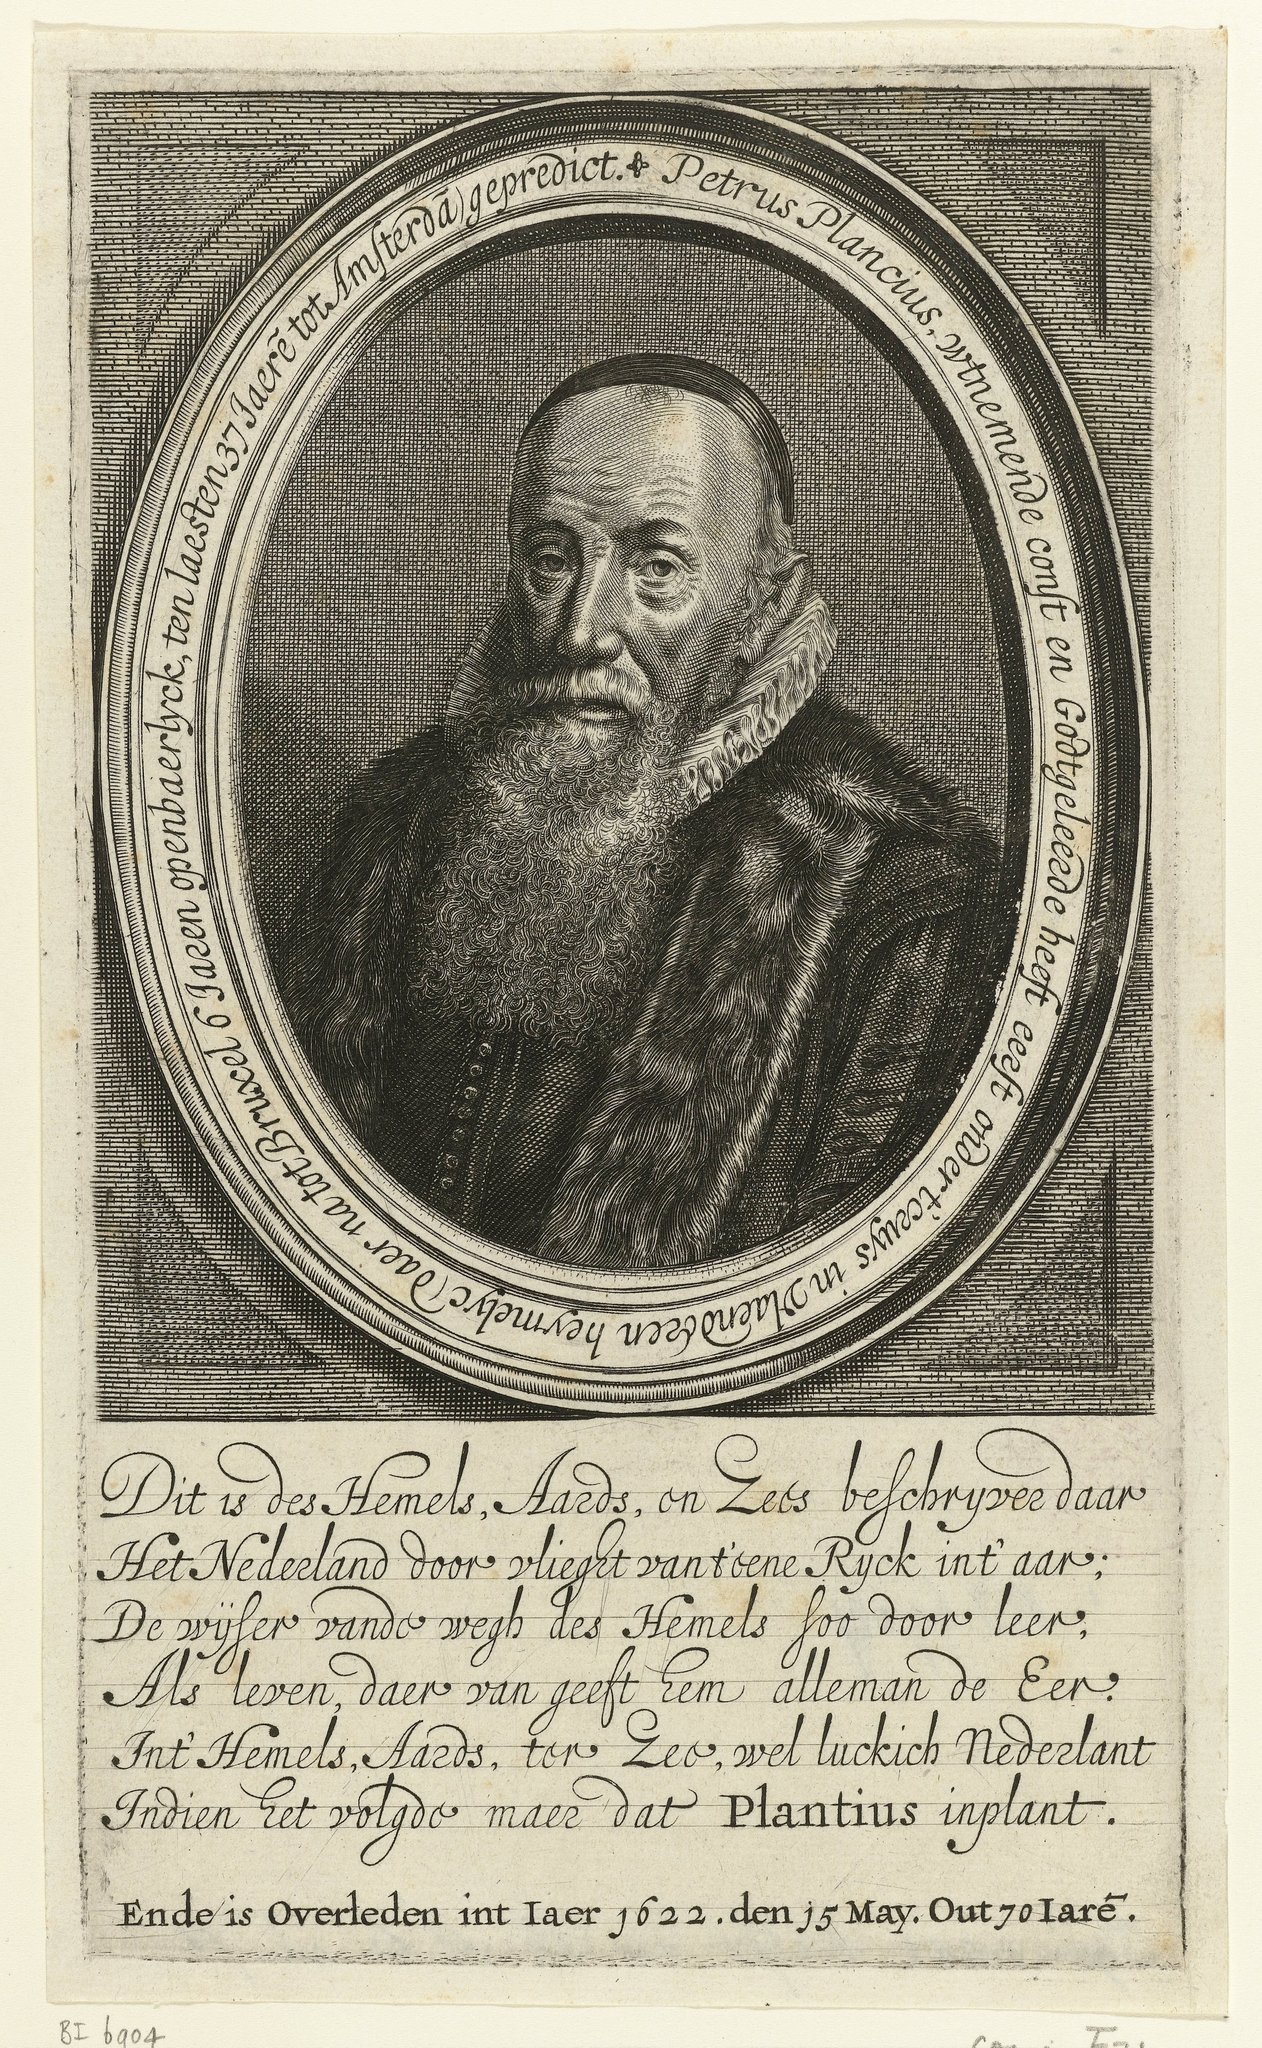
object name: print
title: Portret van Petrus Plancius op 70-jarige leeftijd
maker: Anonymous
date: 1623-1673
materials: paper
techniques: engraving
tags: amsterdam, petrus plancius, theologian, historical persons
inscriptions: collector's mark: Lugt 240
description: Portret van geograaf en theoloog Petrus Plancius op 70-jarige leeftijd, borststuk met baard en toga in ovale omlijsting met Nederlands opschrift. In ondermarge Nederlands vers in zes regels.